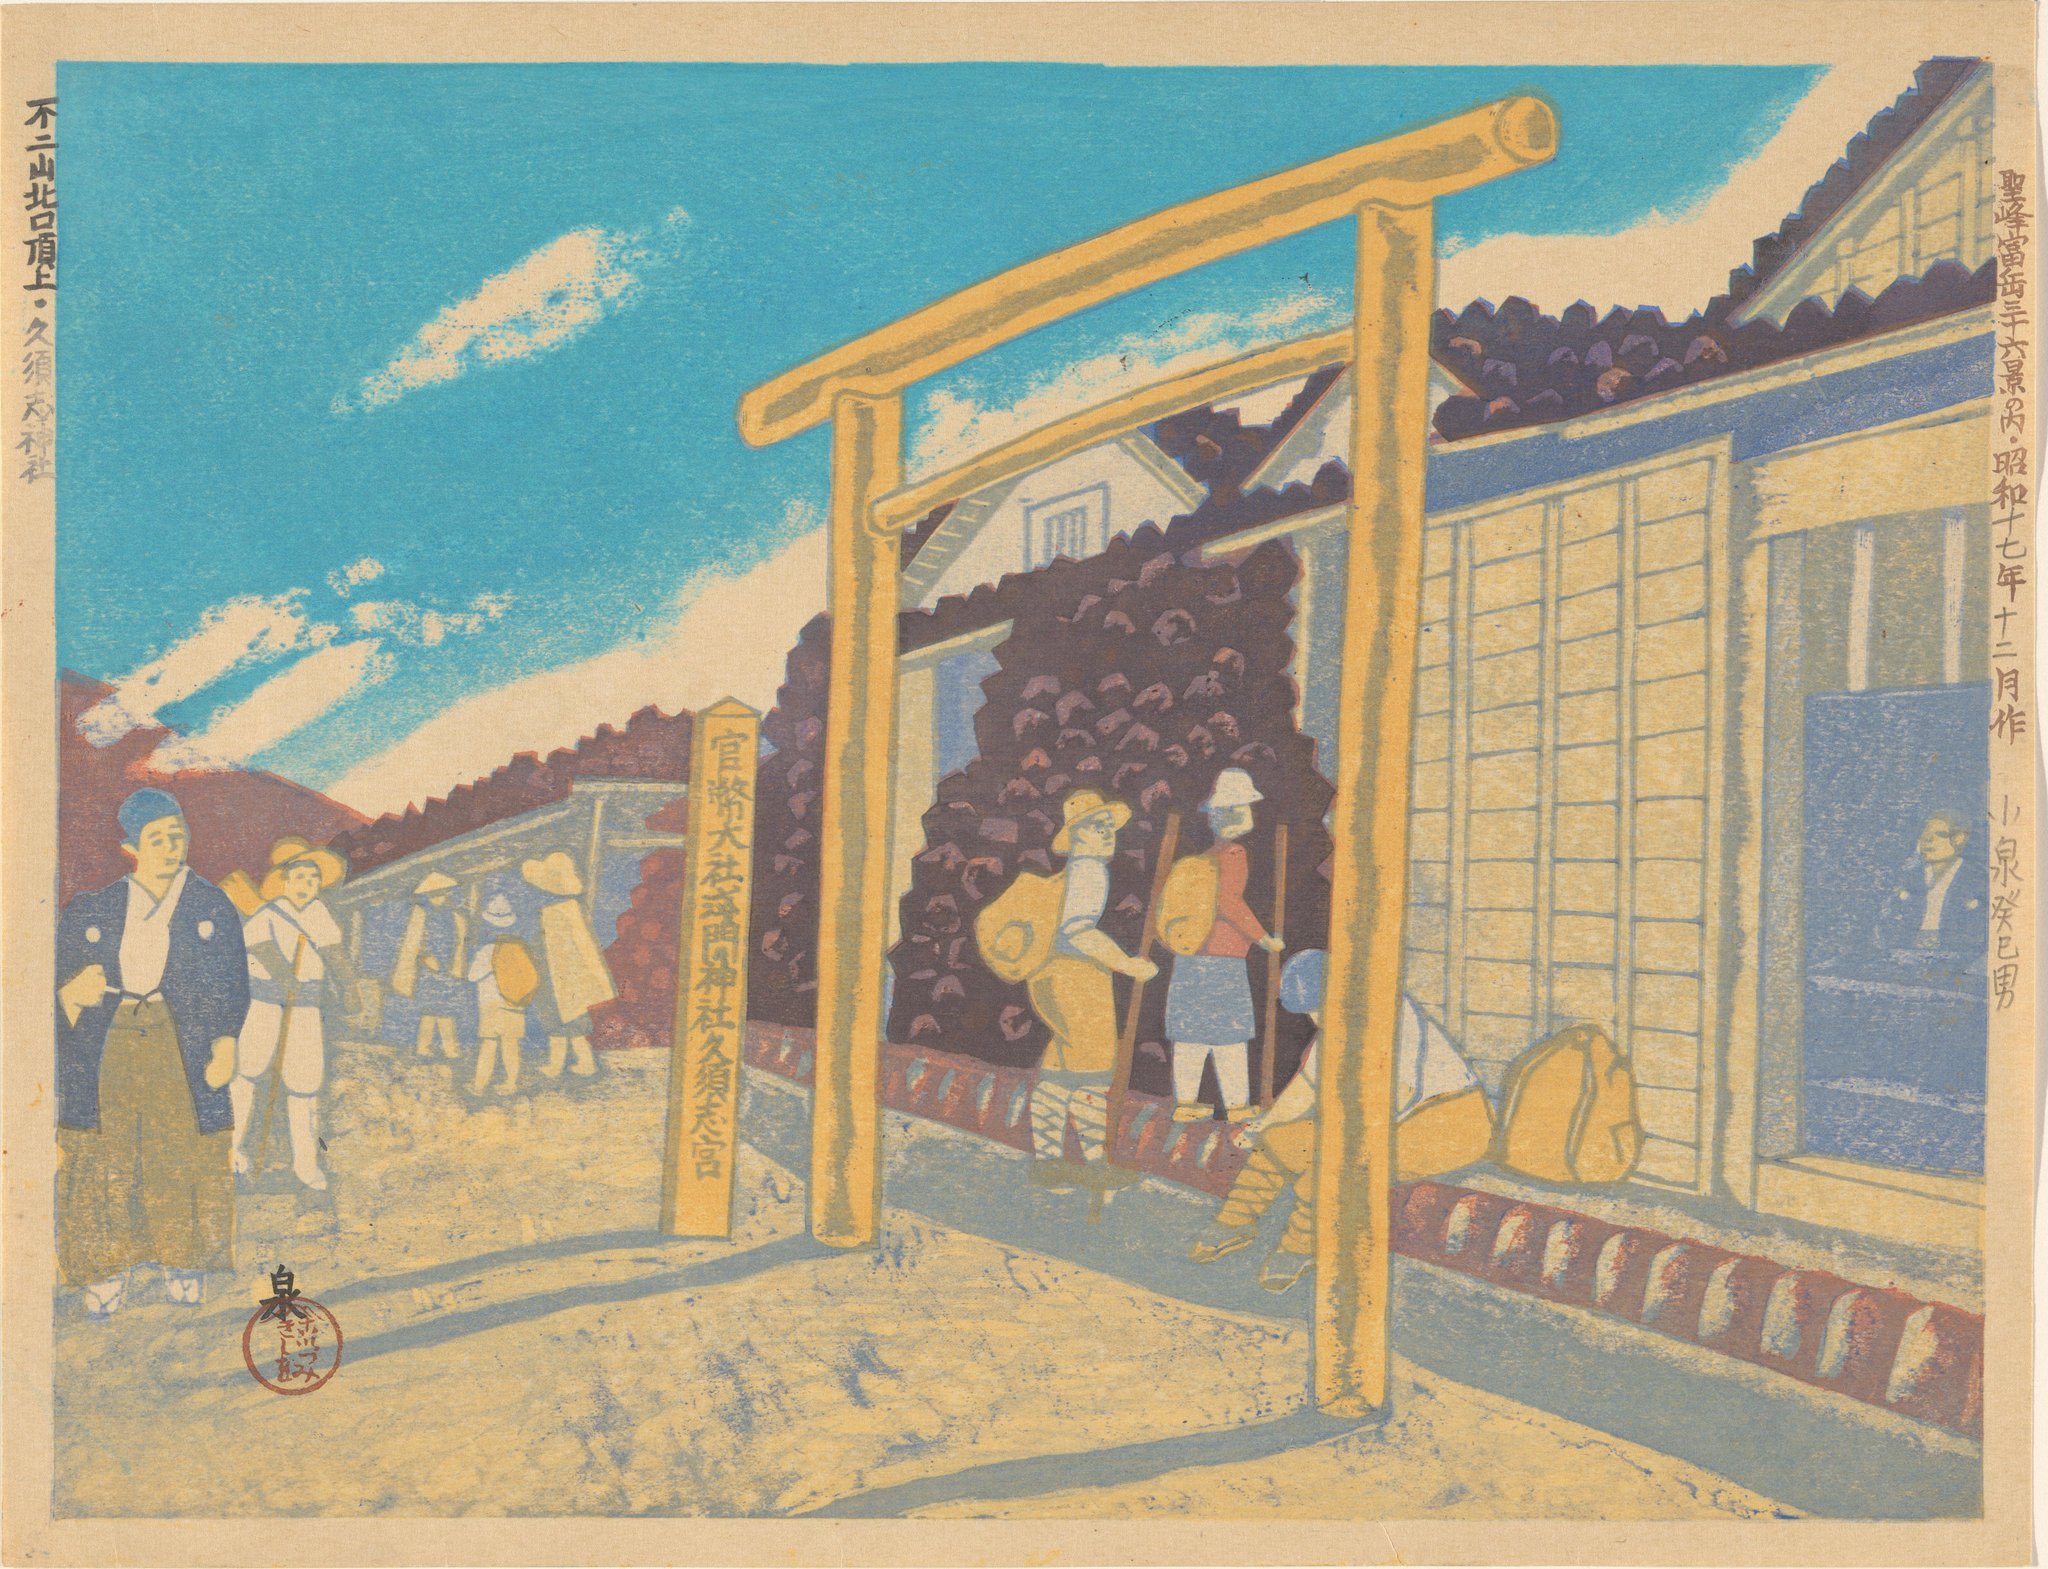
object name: print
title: The northern summit of mount Fuji, the Kusushi Shrine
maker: koizumi kishio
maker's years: 1893-1945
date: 1912-1942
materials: paper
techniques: woodcut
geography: japan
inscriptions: signature: ‘泉’, seal: ‘こいづみきしを’, signature: ‘小泉癸巳男’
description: Diverse bergklimmers komen aan en rusten uit bij het Kusushi-heiligdom aan de noordelijke rand van de krater bovenop de Fuji-berg. Koizumi Kishio begon in 1940 aan zijn project 'Zesendertig gezichten op de heilige berg Fuji', een knipoog naar de welbekende prenten uit de jaren 1830 van Katsushika Hokusai (1760–1849). Vanwege de geallieerde bombardementen vluchtte hij naar zijn schoonouders in Saitama, ten noorden van Tokyo. Hij voltooide 23 ontwerpen voor hij bezweek aan ziekte in 1945.